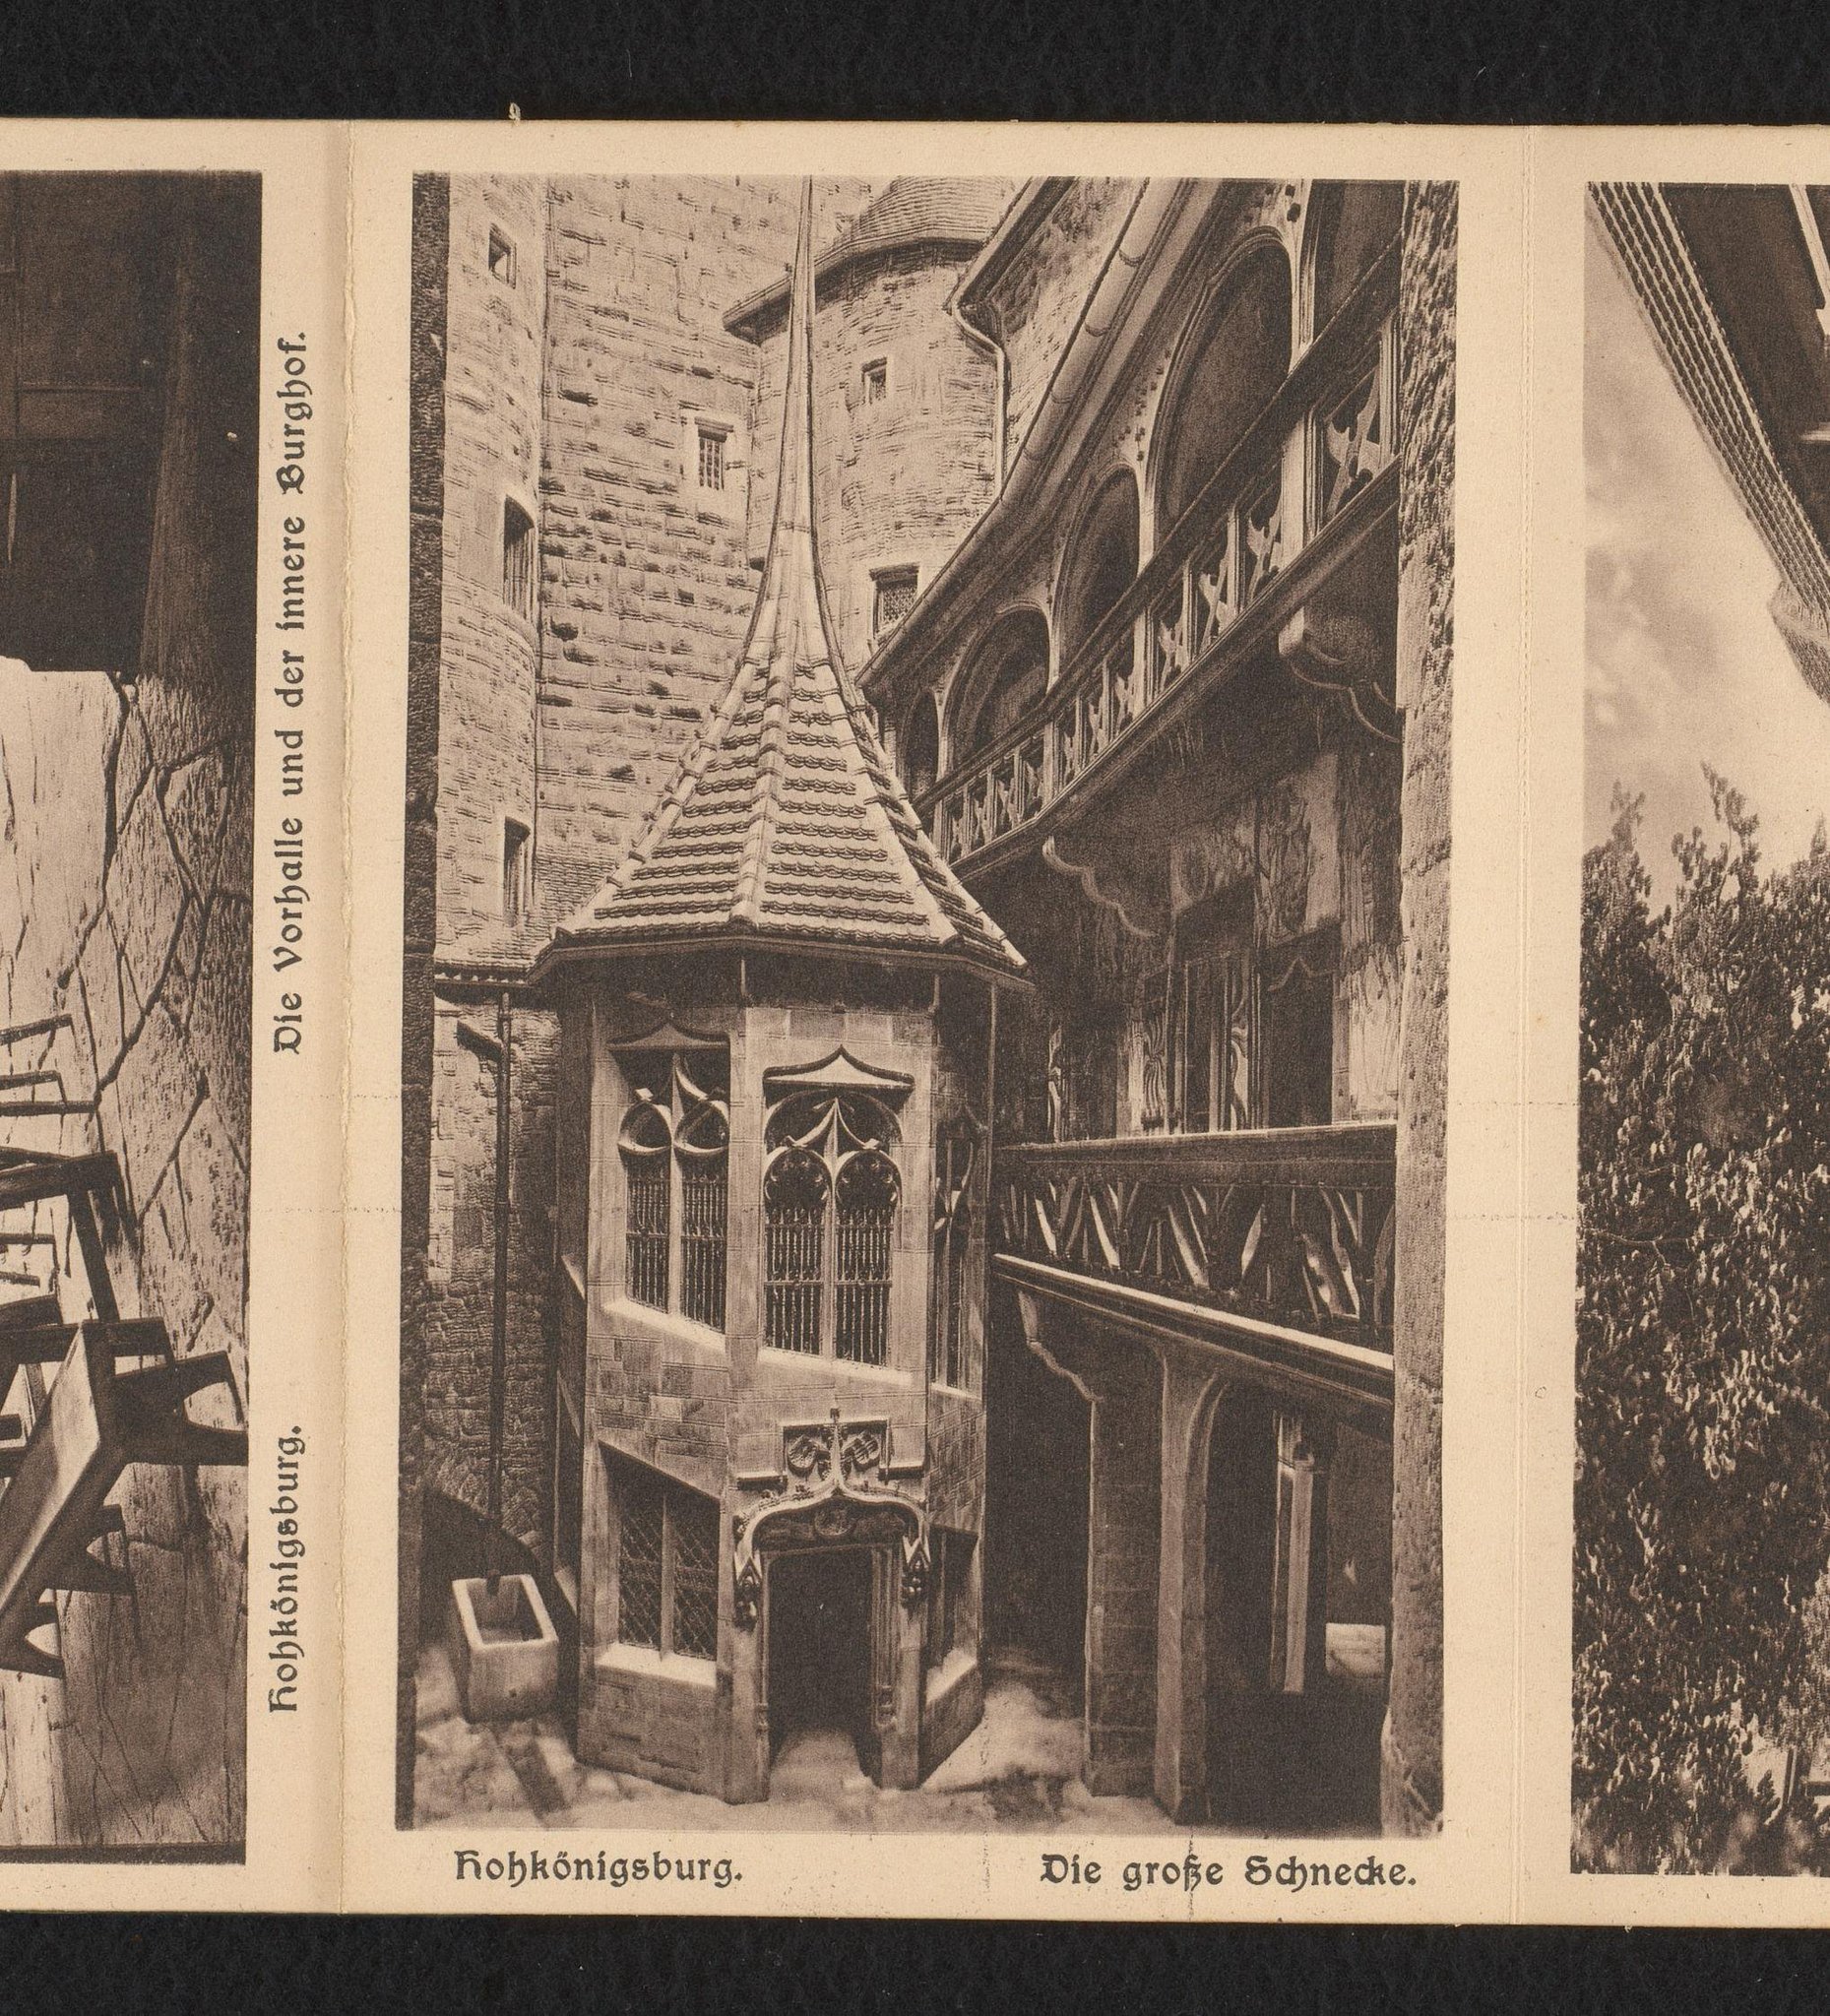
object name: photomechanical print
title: Hohkönigsburg. Die Groβe Schnecke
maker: Anonymous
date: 1908-1913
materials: cardboard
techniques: photograph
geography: alsace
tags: castle